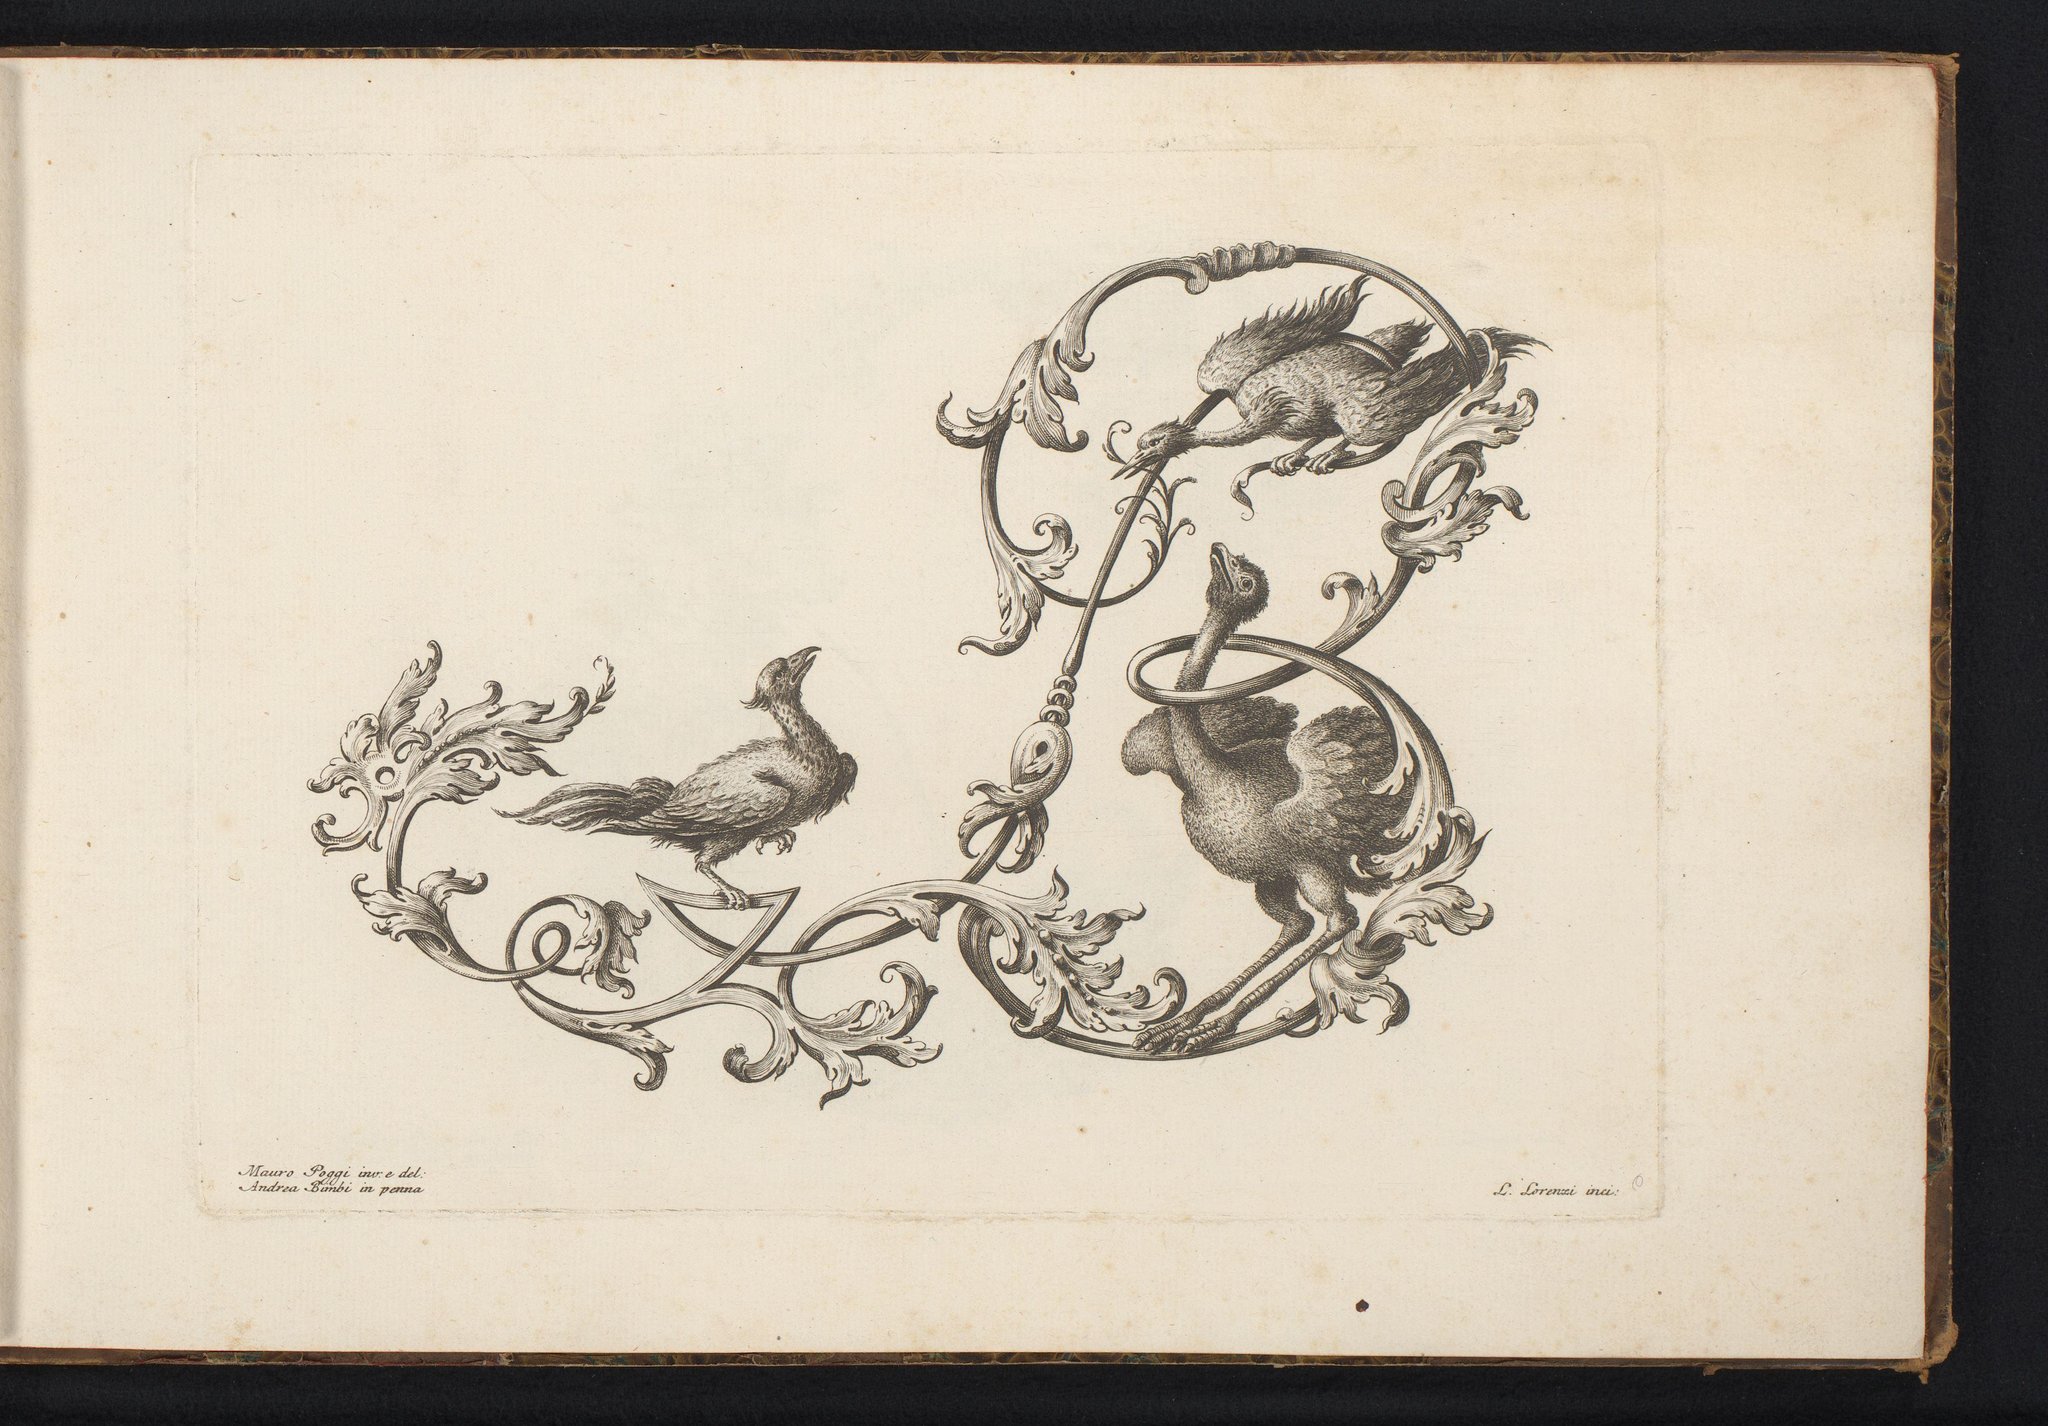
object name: album leaf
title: Ornamentele letter B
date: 1745-1765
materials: paper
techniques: engraving, etching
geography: italy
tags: letters, alphabet, script, fancy letters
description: Ornamentele letter B, versierd met twee vogels en een struisvogel. Prent maakt deel uit van een album.